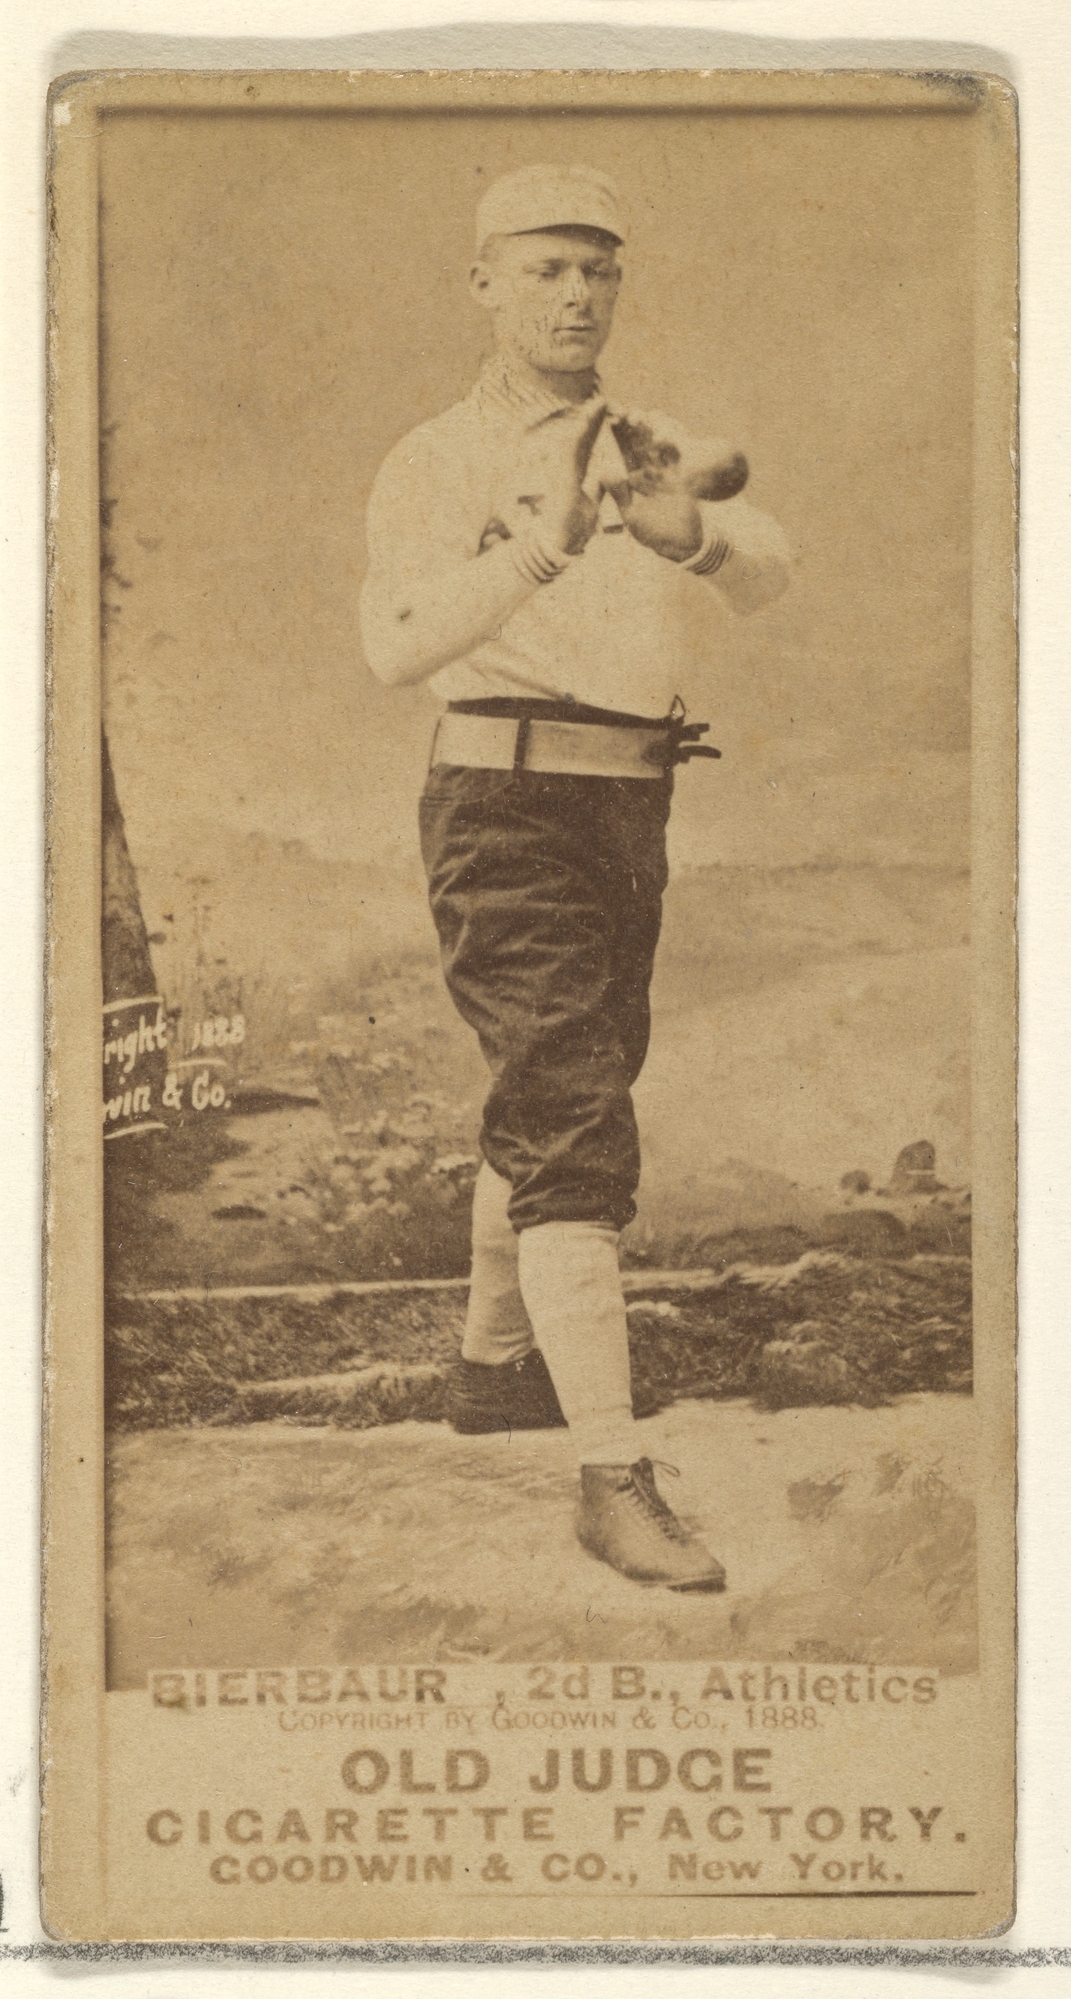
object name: baseball card, photograph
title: Bierbauer, 2nd Base, Philadelphia Athletics, from the Old Judge series (N172) for Old Judge Cigarettes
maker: goodwin & company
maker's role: publisher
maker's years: 1850-1950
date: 1888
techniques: albumen silver print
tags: men,portraits,baseball,athletes